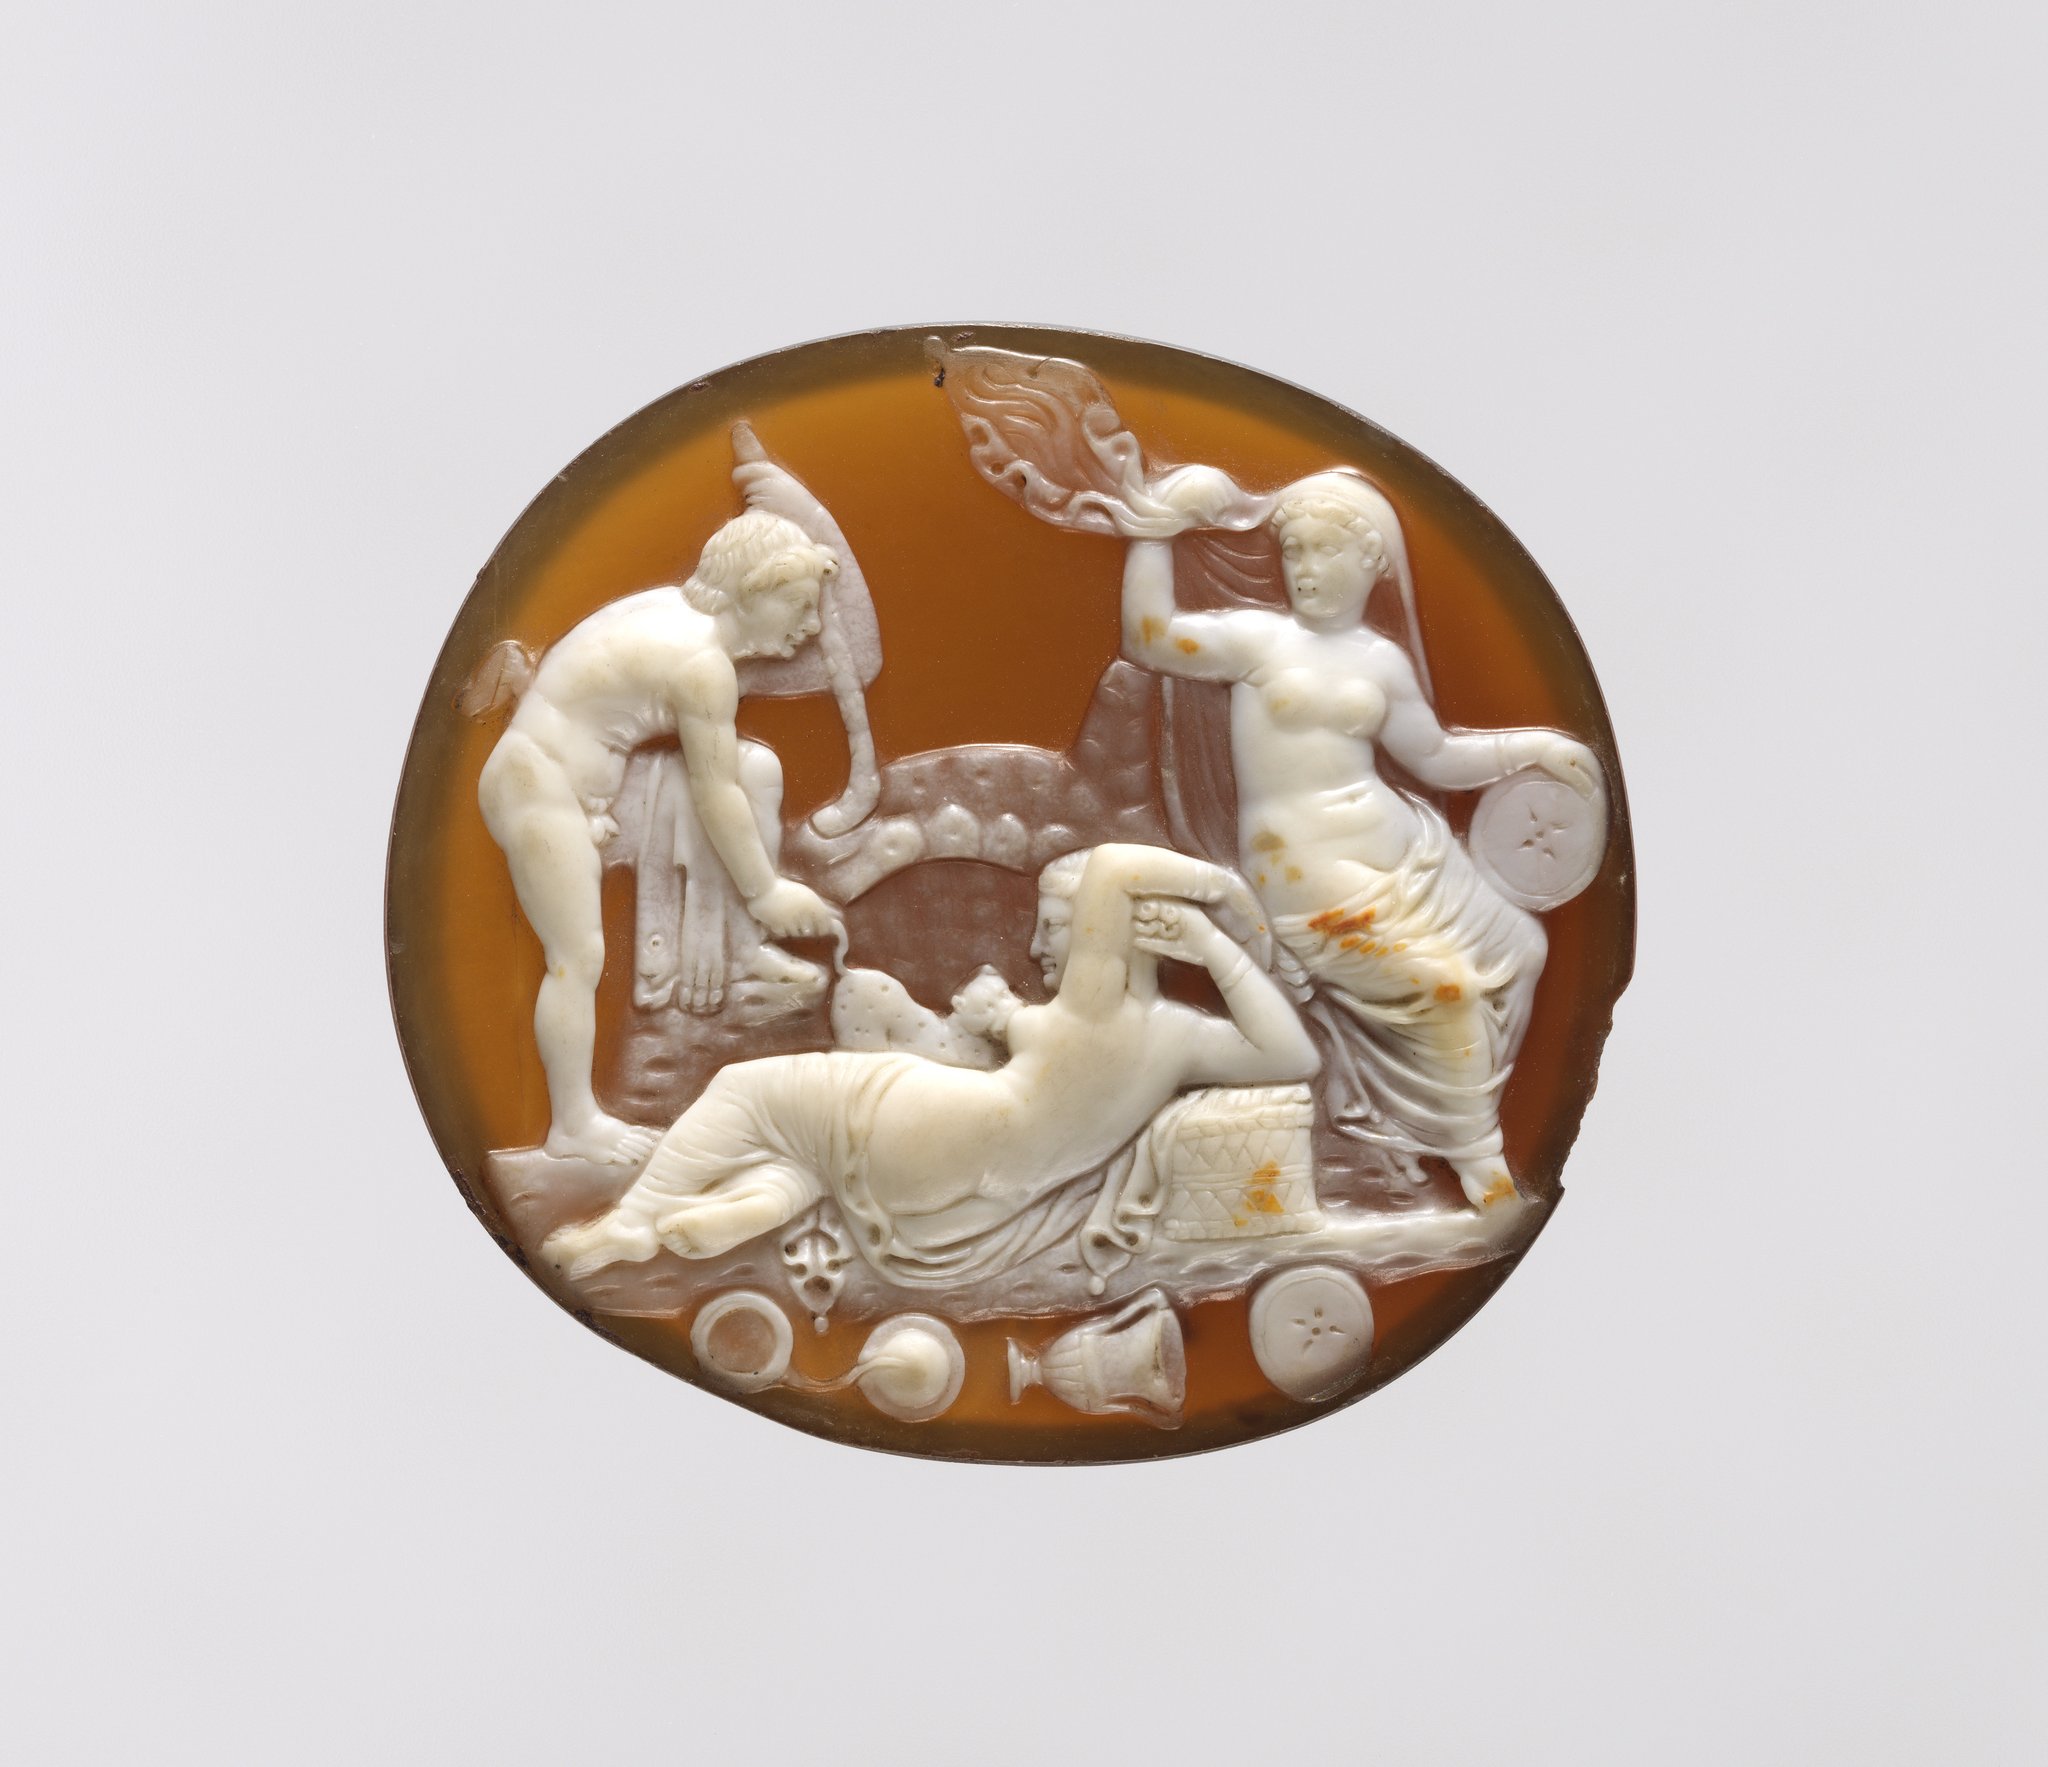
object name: cameo, sardonyx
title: Sardonyx cameo with a Bacchic group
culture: greek or roman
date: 100 BCE-100 CE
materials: gemstone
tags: maenads,satyrs